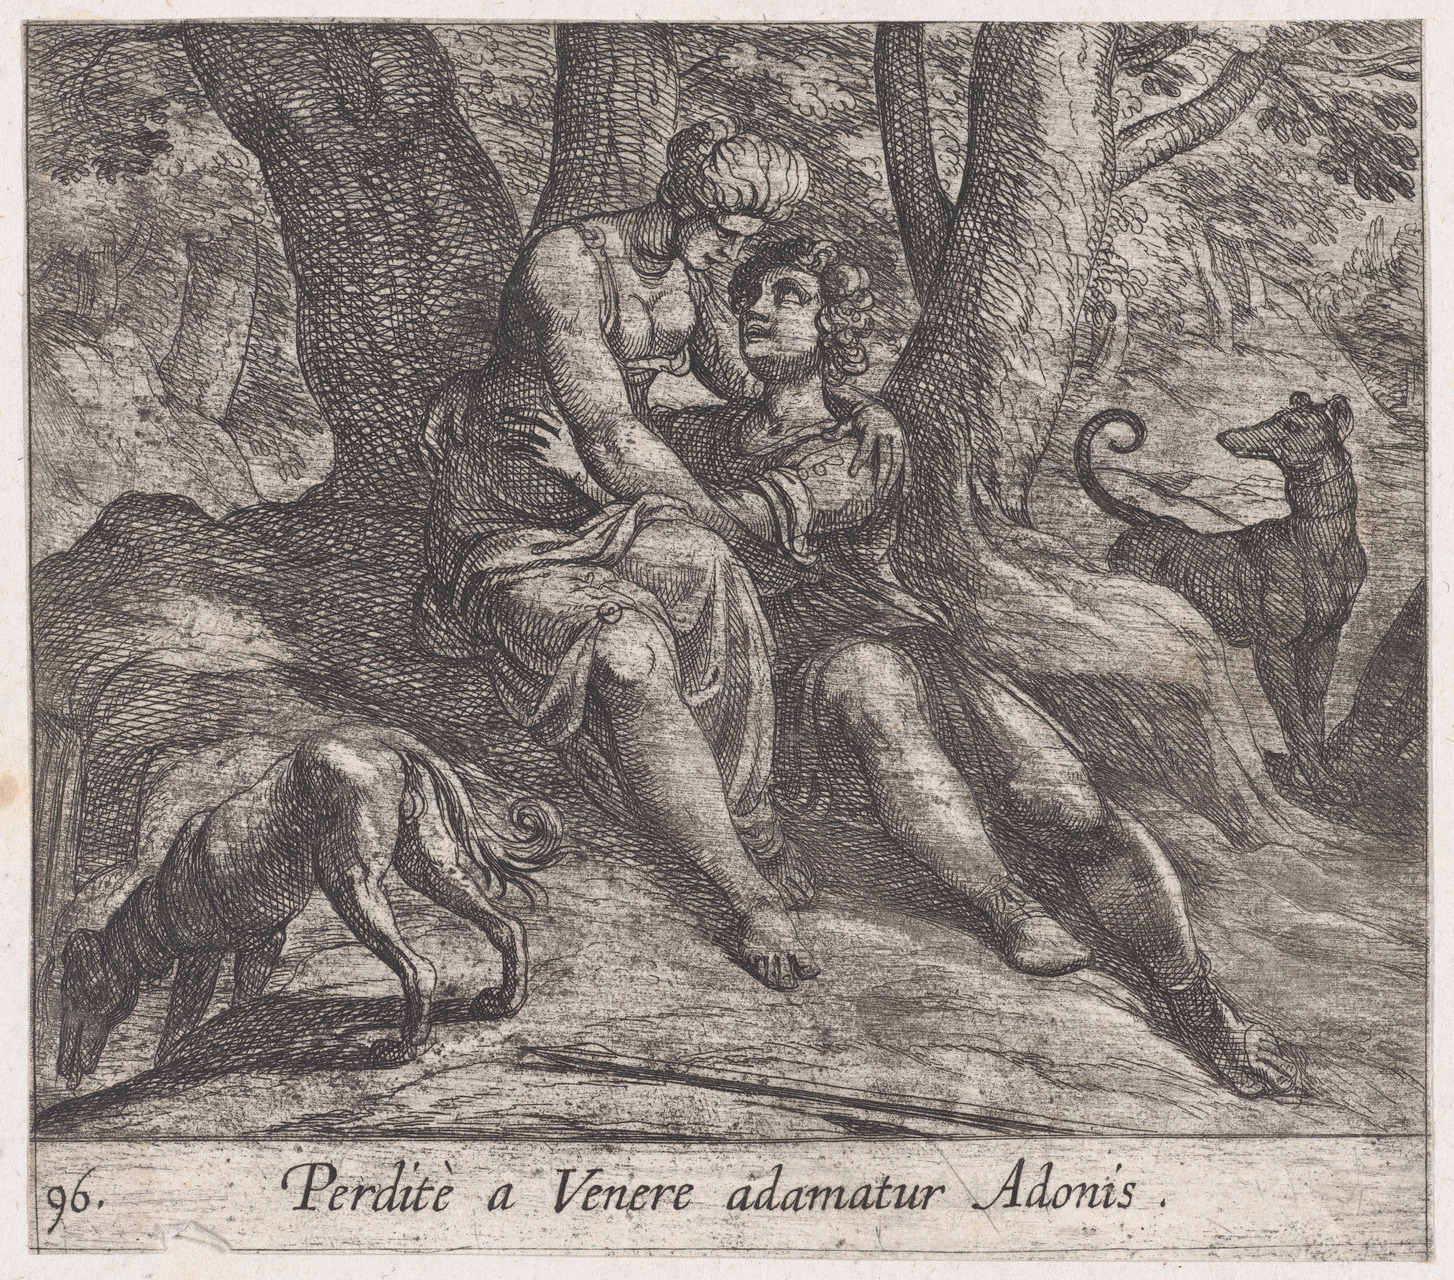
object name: print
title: Plate 96: Venus and Adonis Embracing (Perditè a Venere adamatur Adonis), from Ovid's 'Metamorphoses'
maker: antonio tempesta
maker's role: artist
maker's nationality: italian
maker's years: 1555-1630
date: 1606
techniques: etching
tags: adonis,venus,dogs